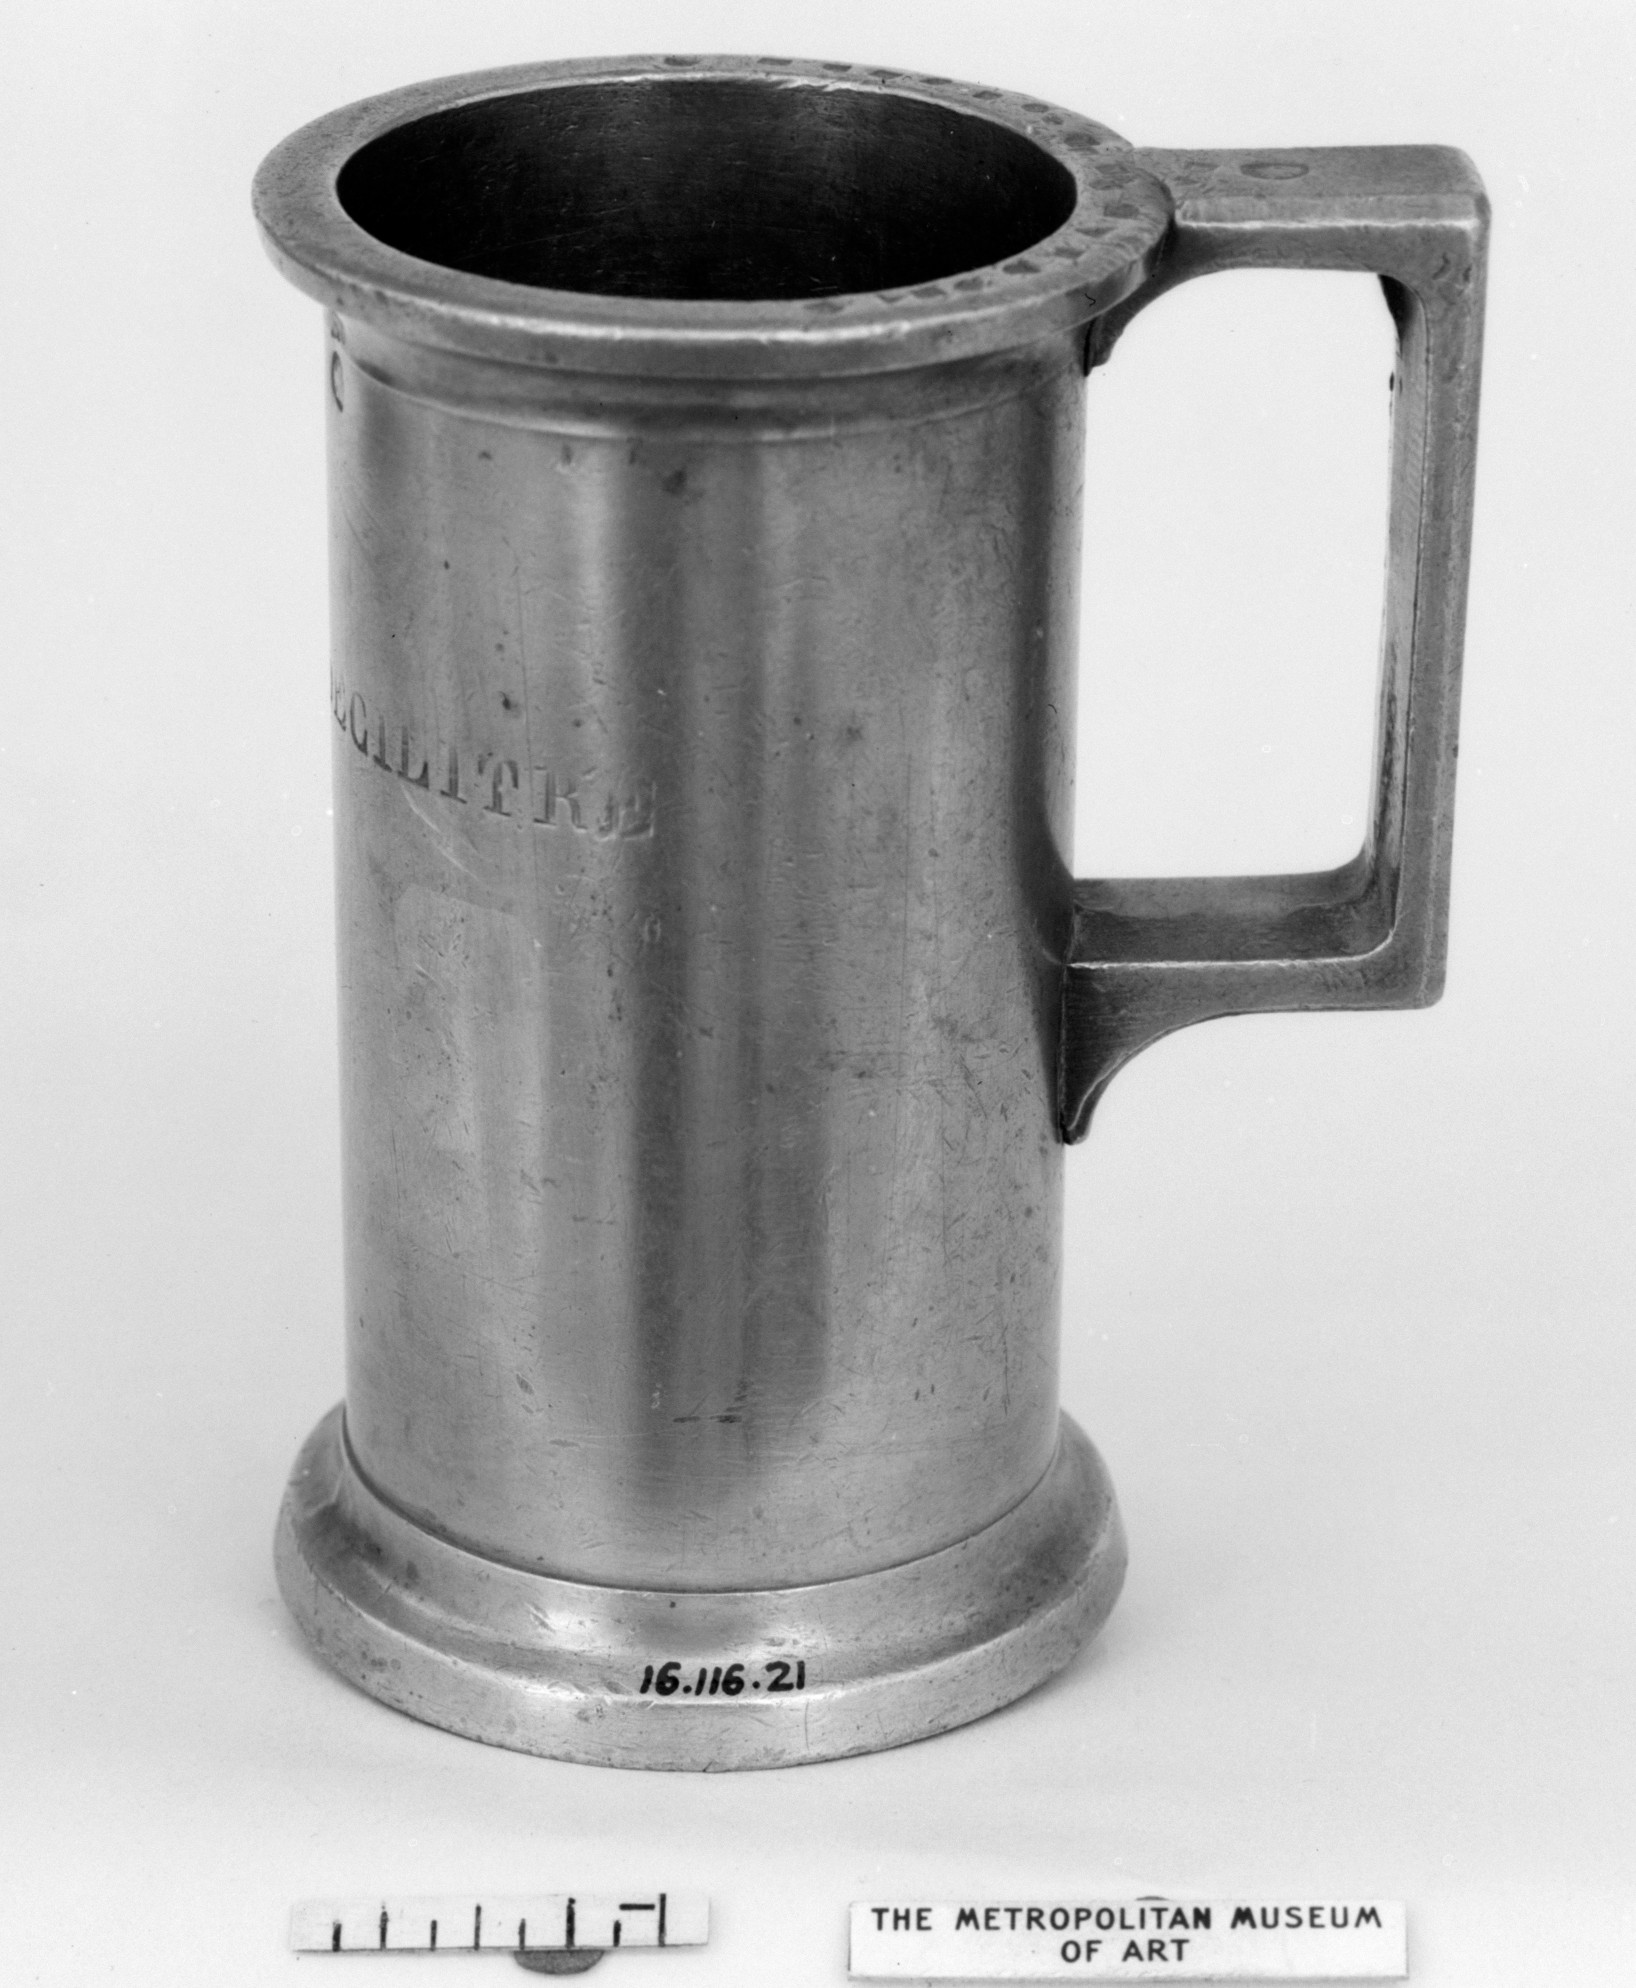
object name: measure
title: Measure (one of a set of seven)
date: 1801-1900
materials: pewter